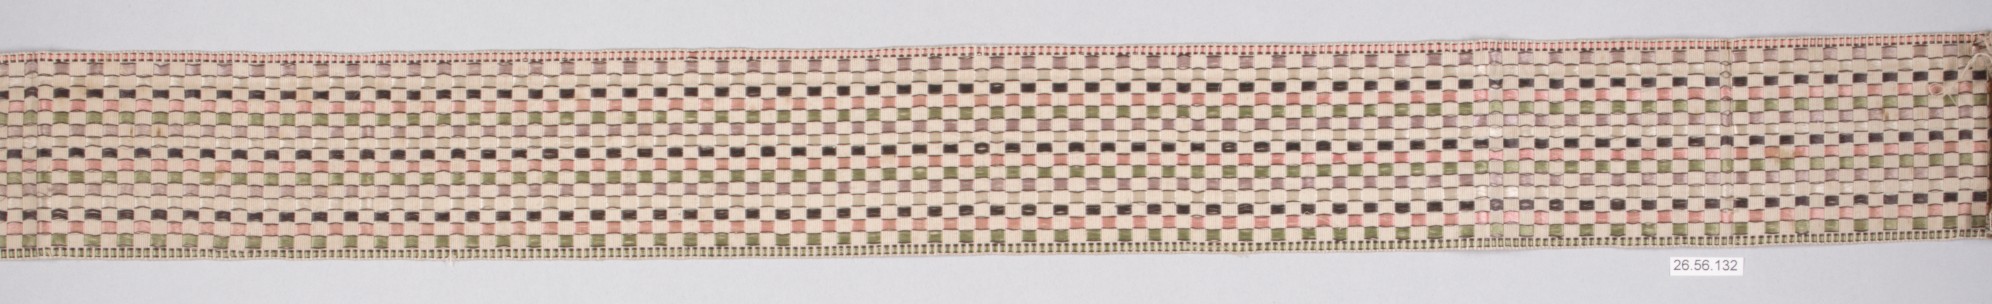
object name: ribbon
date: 1826-1850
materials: silk